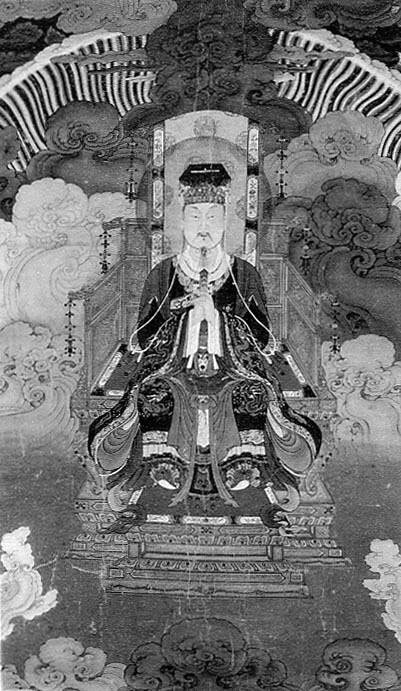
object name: hanging scroll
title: Taoist Diety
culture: chinese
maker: unidentified artist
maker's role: artist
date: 1368-1911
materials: silk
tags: deities,daoism